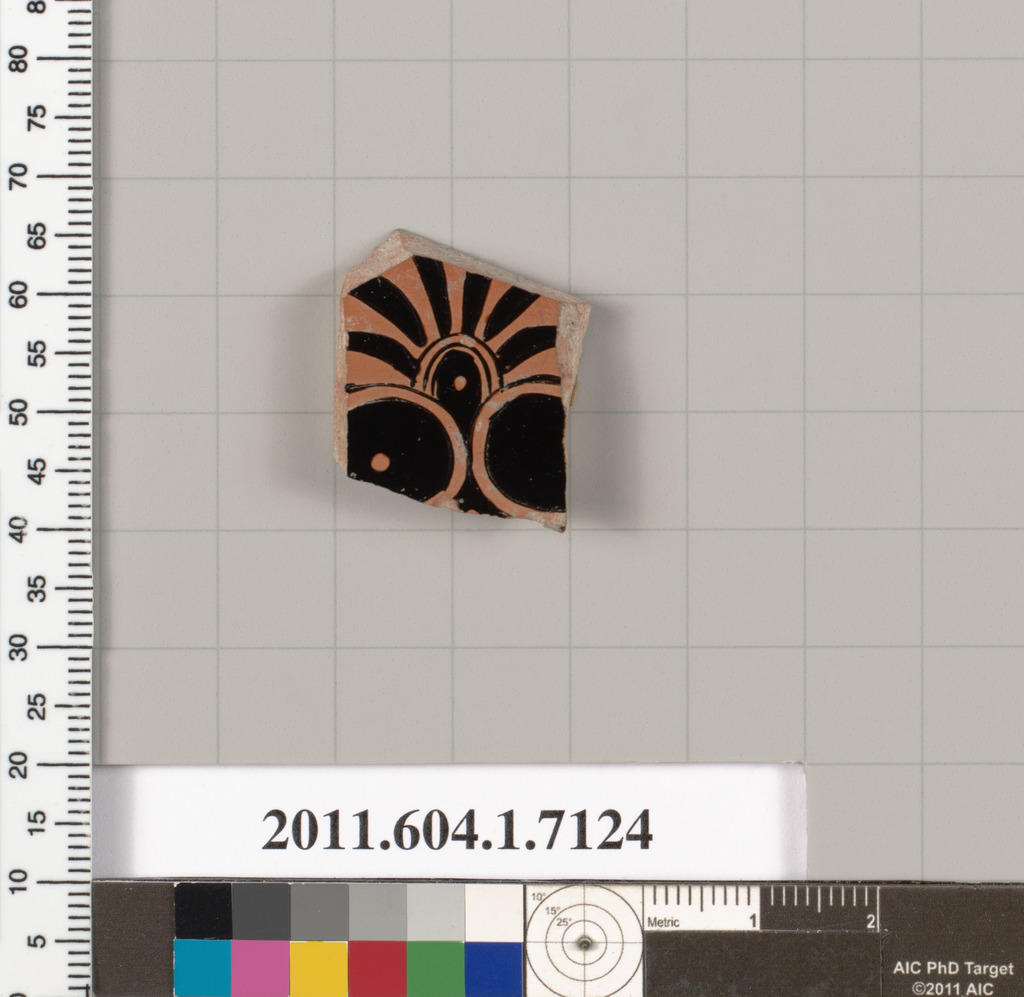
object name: kylix fragment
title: Terracotta fragment of a kylix (drinking cup)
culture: greek, attic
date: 500-480 BCE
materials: terracotta